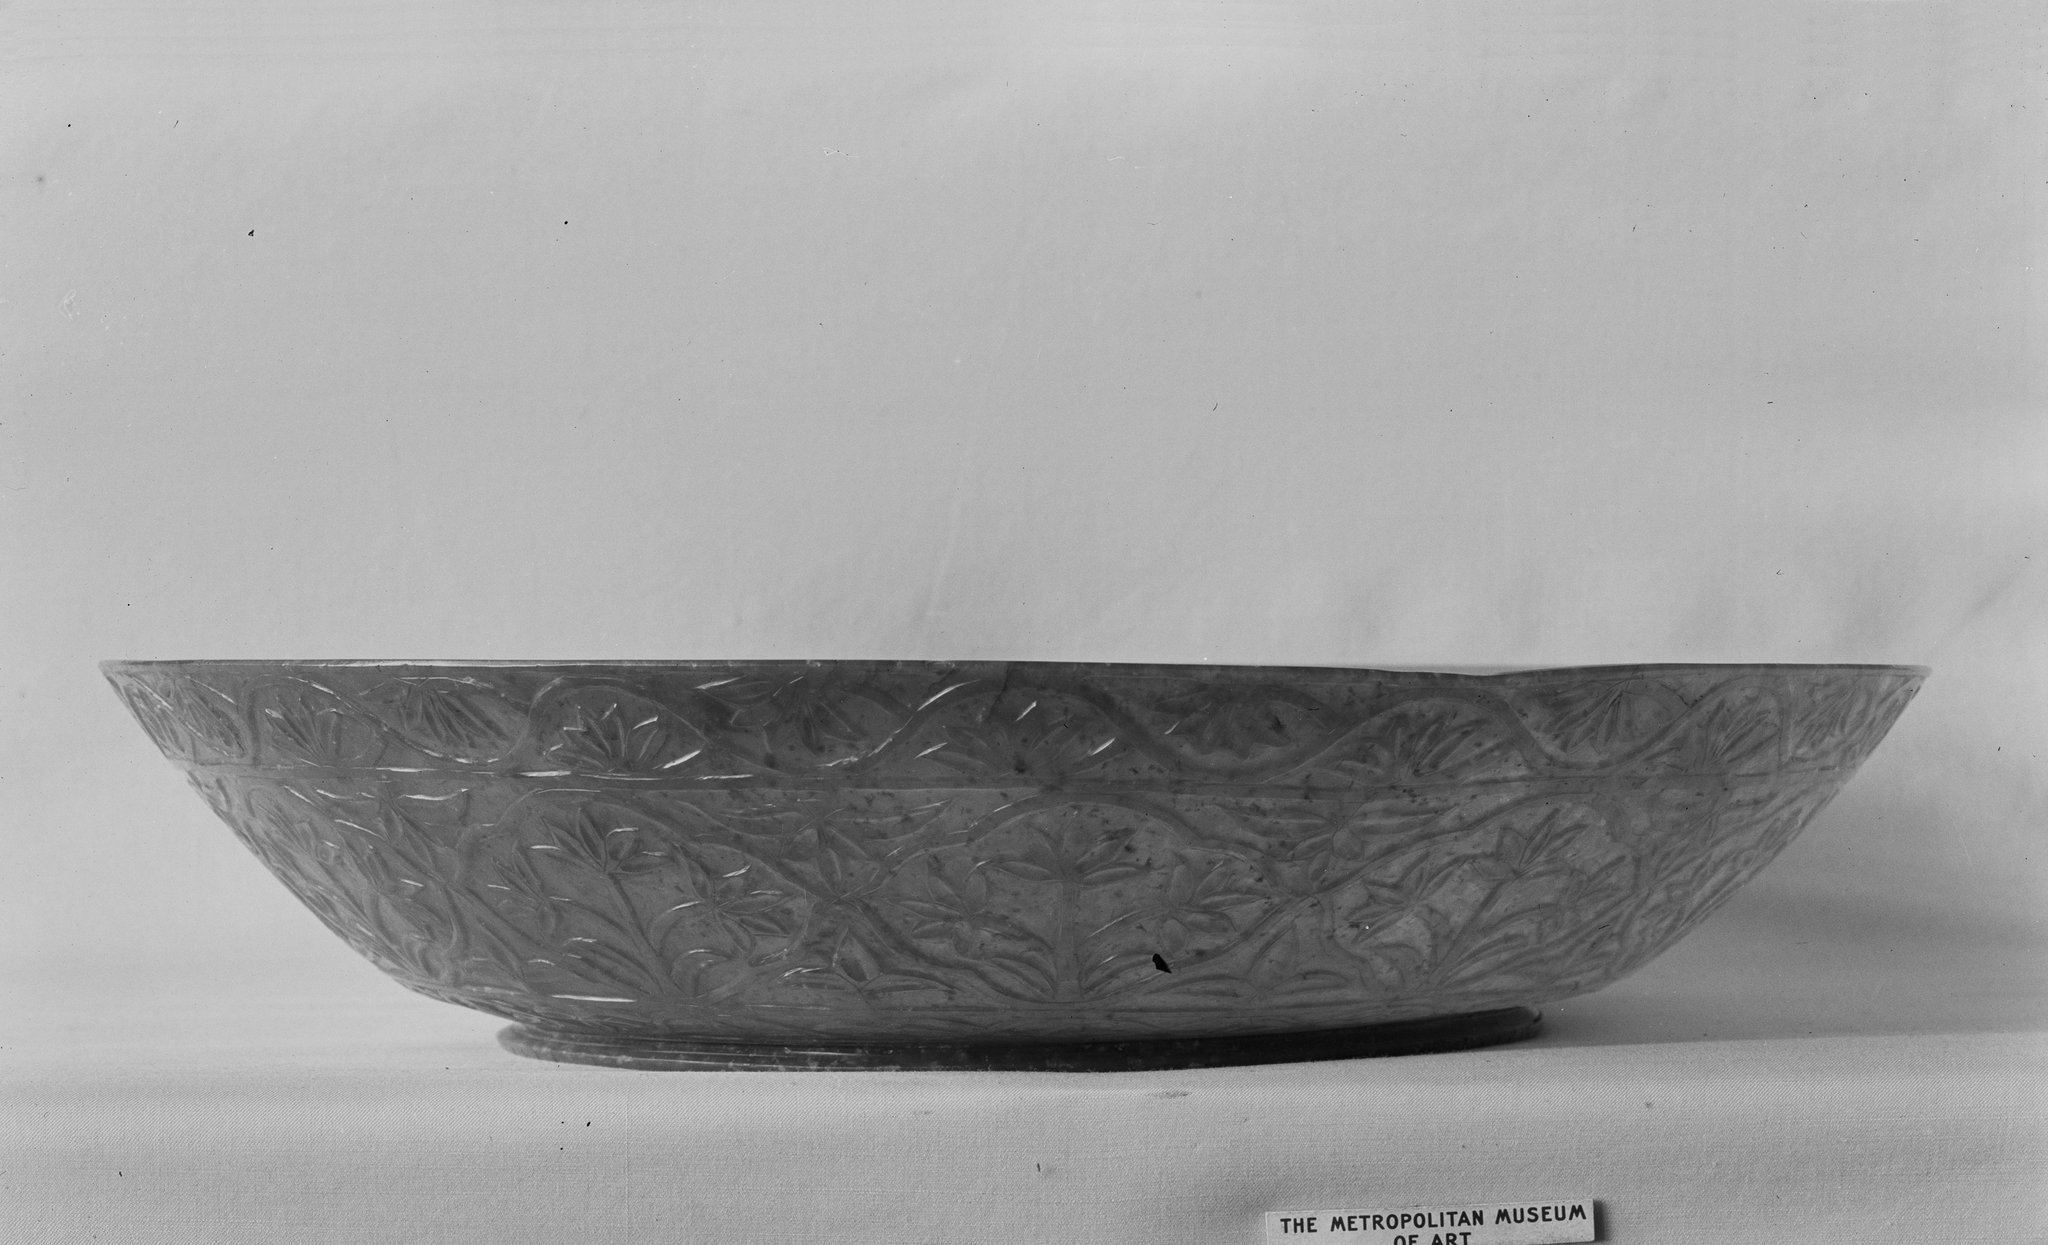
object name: dish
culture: chinese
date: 1736-1795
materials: jade